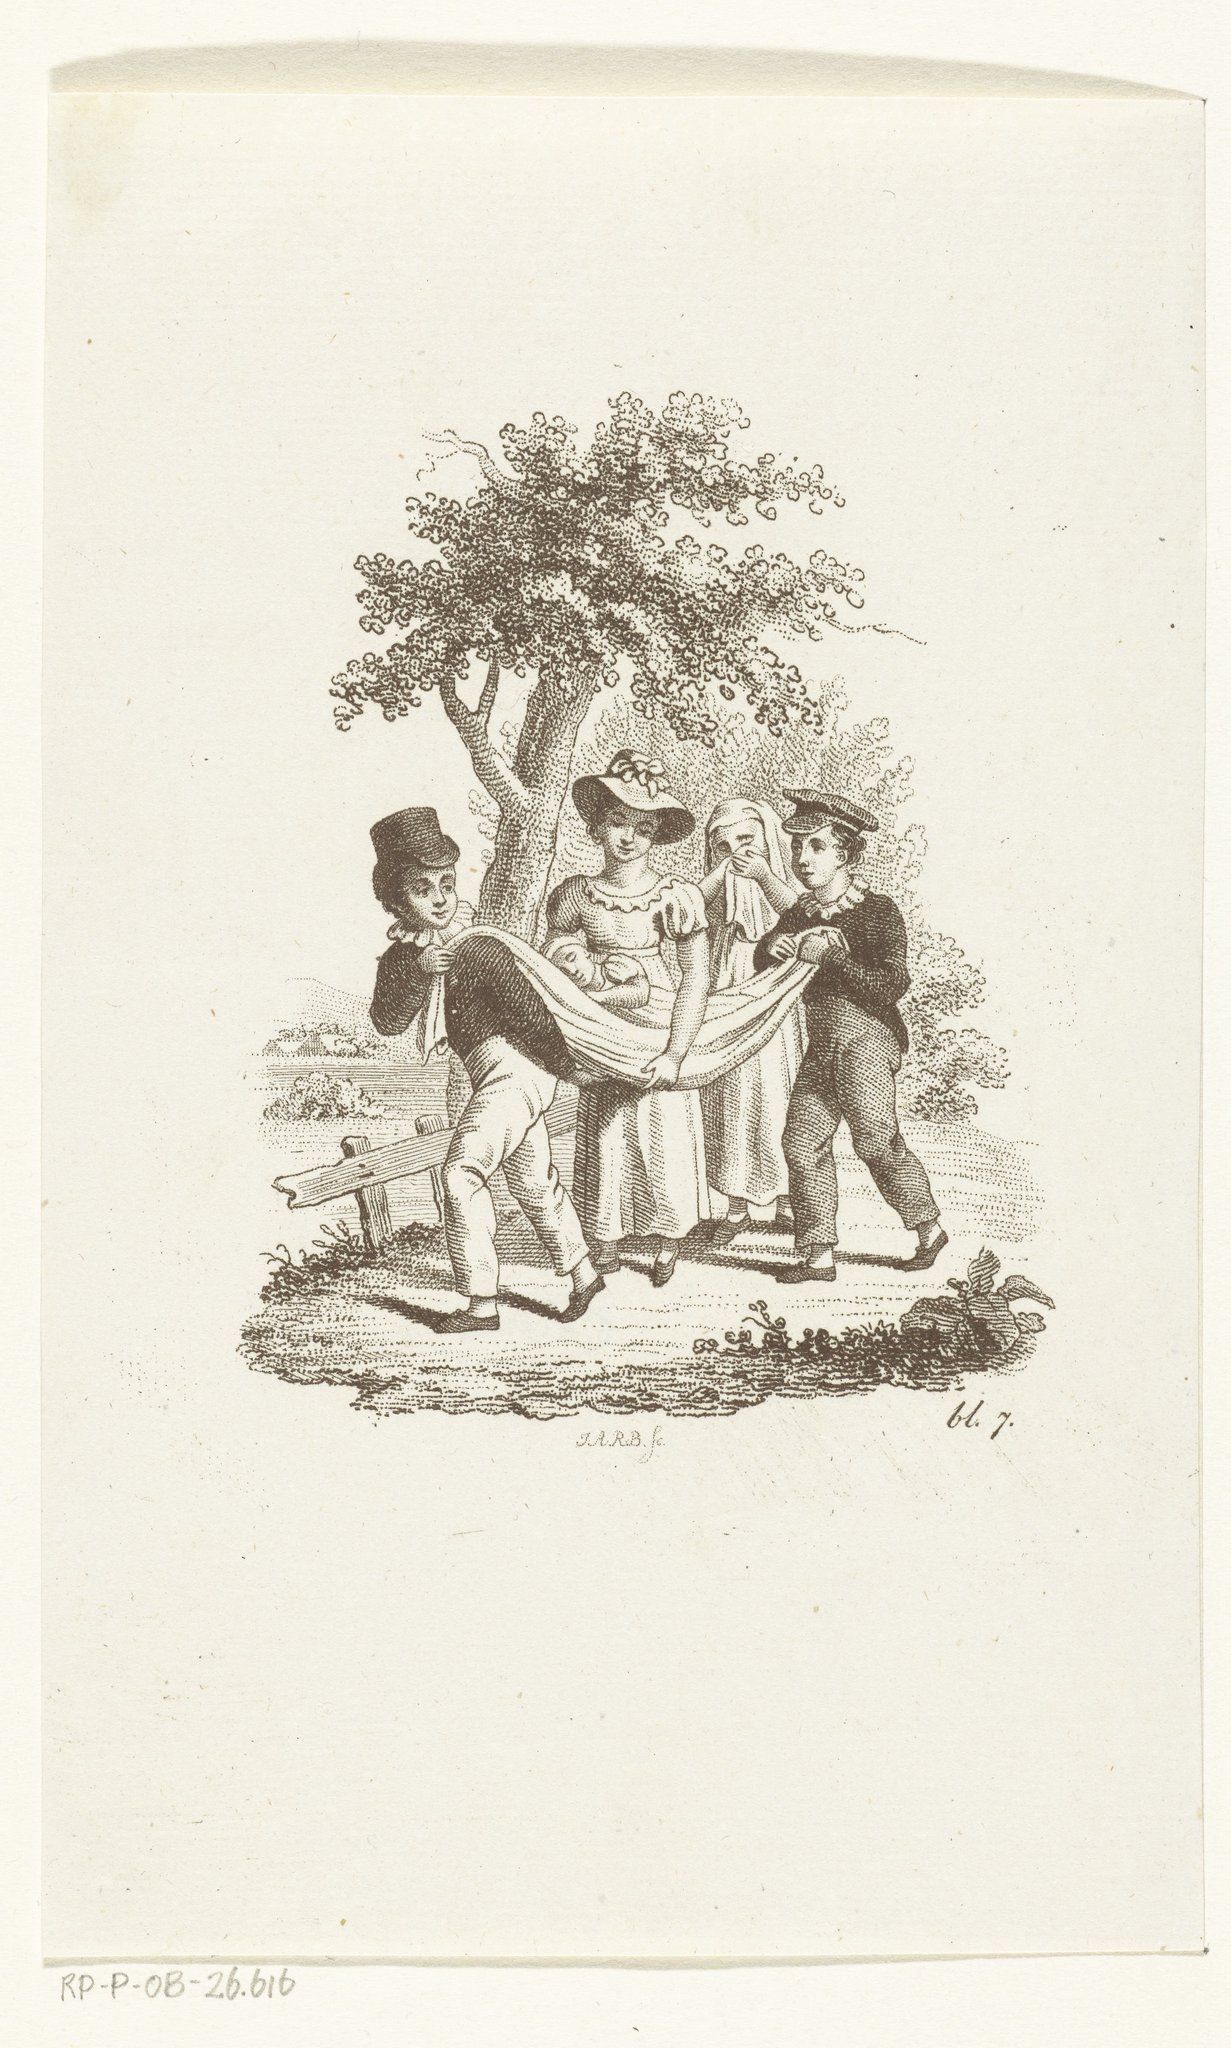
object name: print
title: Twee jongens dragen (ziek) kind in doek en vrouw huilt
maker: johannes alexander rudolf best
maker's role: print maker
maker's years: 1797-1855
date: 1807-1855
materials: paper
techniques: etching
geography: amsterdam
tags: child, patient, sick person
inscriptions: inscription: ‘bl. 7.’, collector's mark: Lugt 2228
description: Prent gebruikt als boekillustratie in onbekende uitgave, illustratie bij tekst op p. 7.